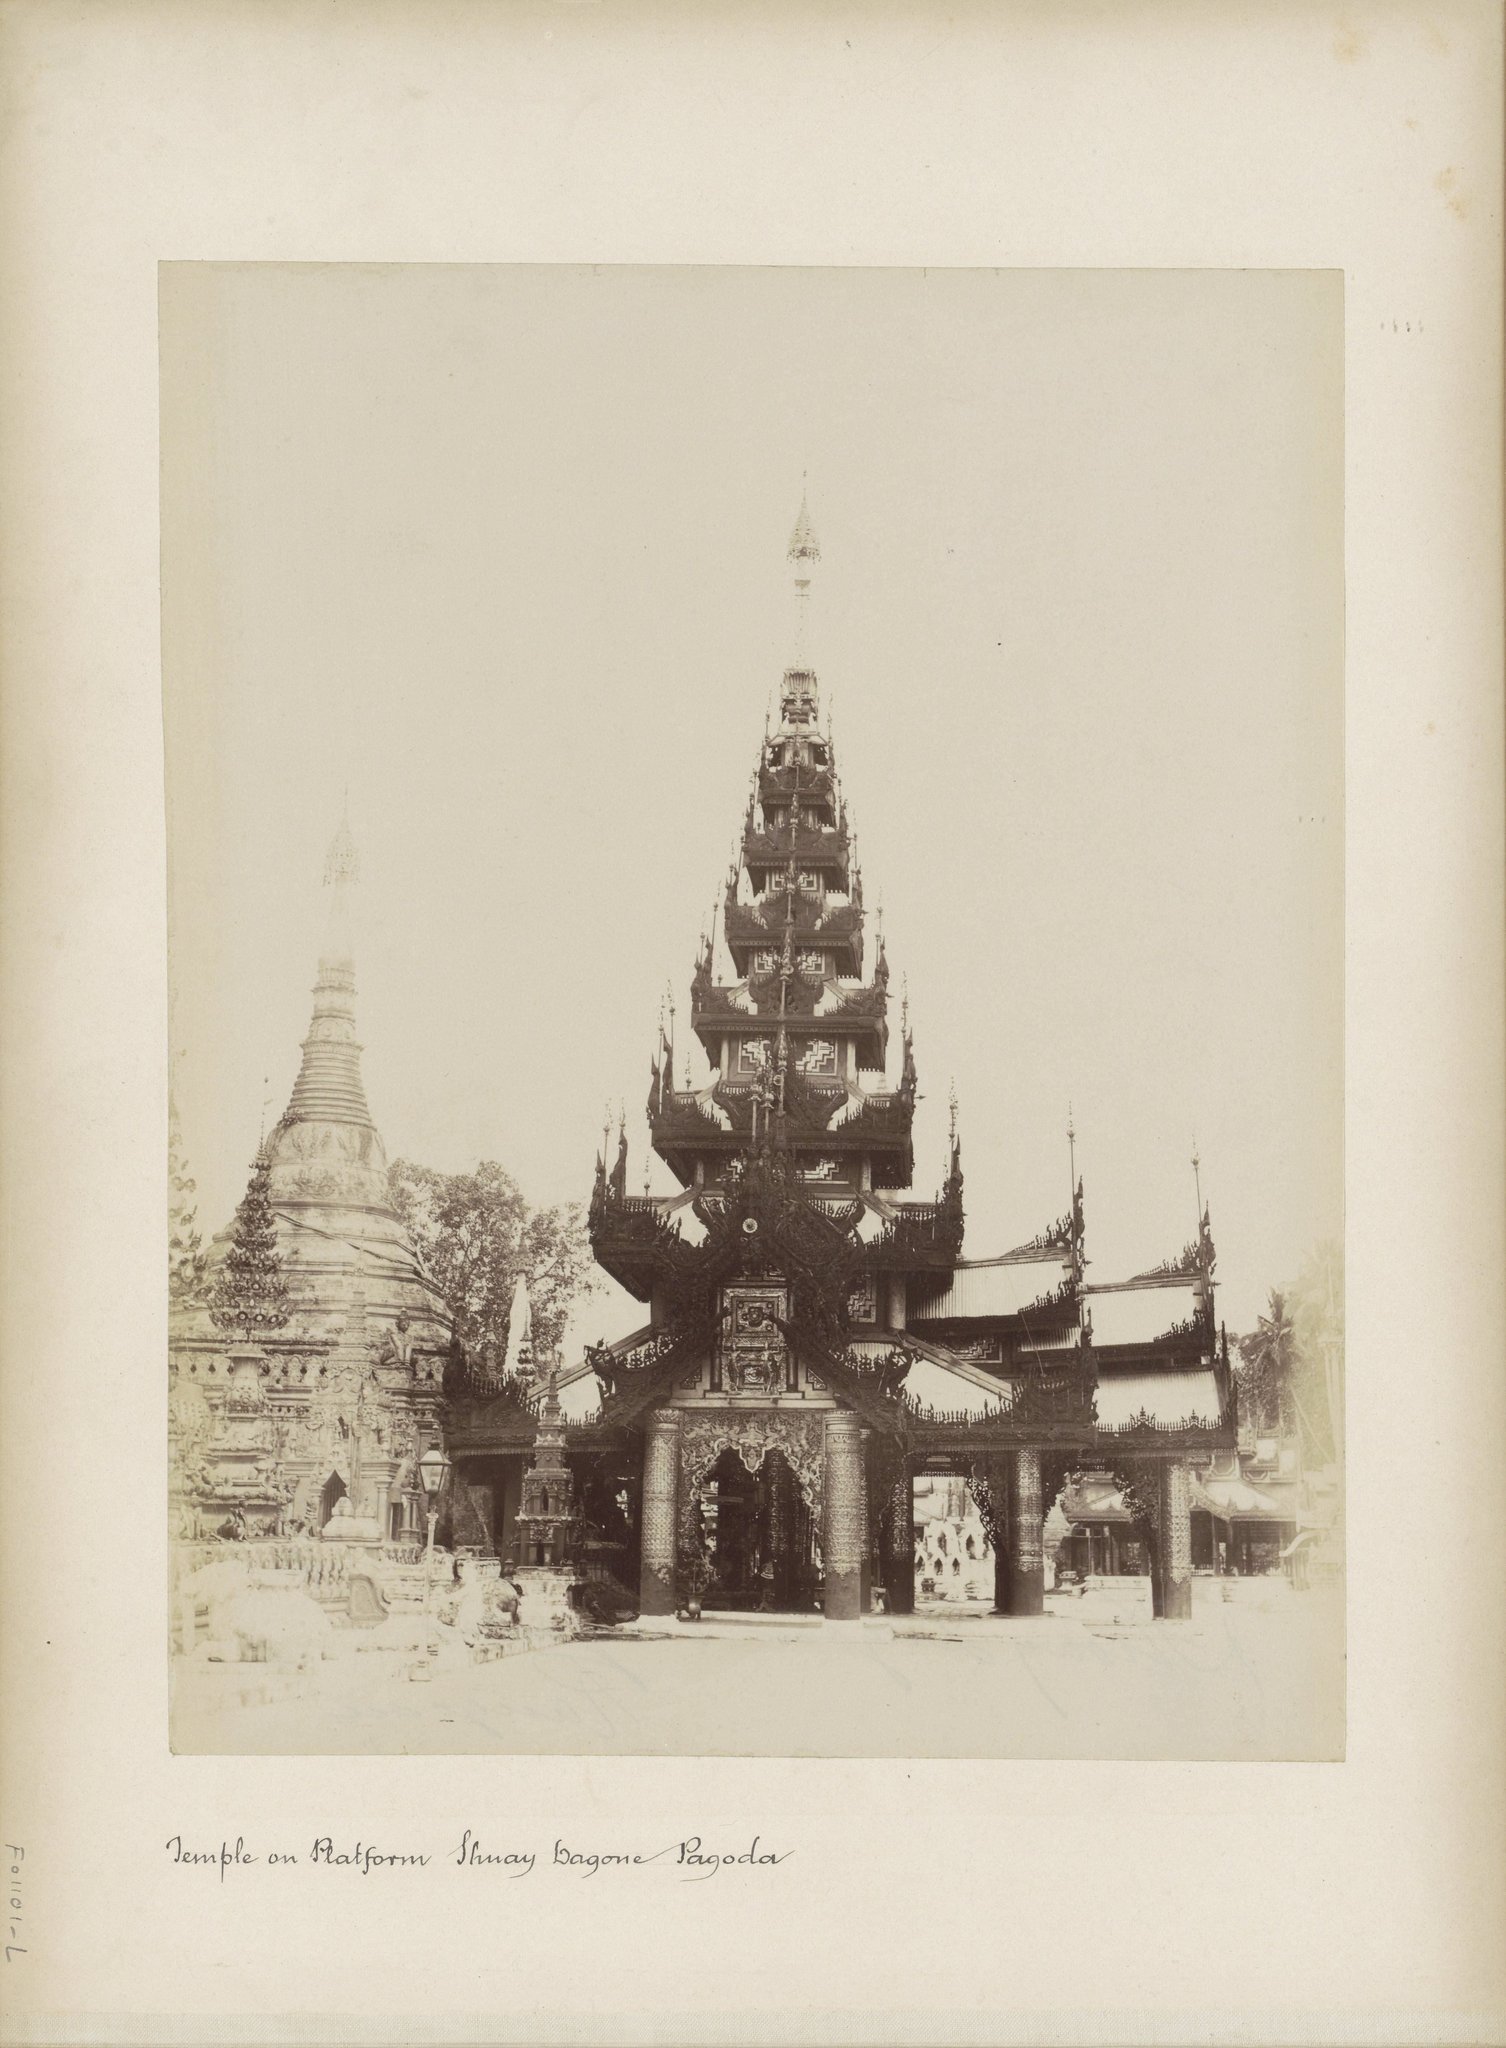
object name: album leaf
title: Temple at the Shwedagon Pagoda, Yangon, Myanmar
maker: philip adolphe klier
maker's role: fotograaf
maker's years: 1845-1911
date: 1885-1886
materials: cardboard, paper, photographic support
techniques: albumen print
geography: yangon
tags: temple, shrine ~ hinduism, buddhism, jainism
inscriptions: caption: ‘Temple on Platform Shway Dagone Pagoda’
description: Onderdeel van Reisalbum met foto's van bezienswaardigheden in Birma.